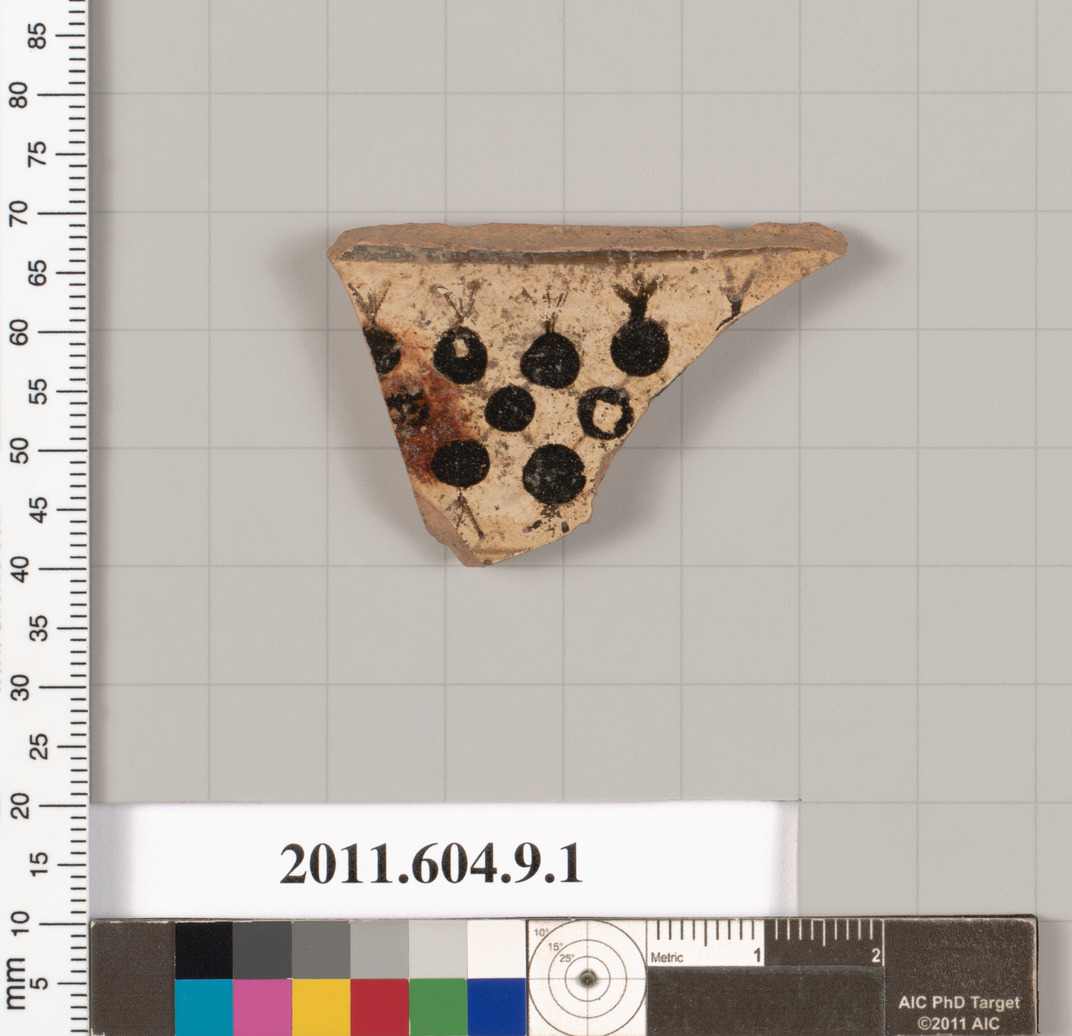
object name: kylix fragment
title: Terracotta fragment of a kylix (drinking cup)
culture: greek, laconian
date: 565-550 BCE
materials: terracotta